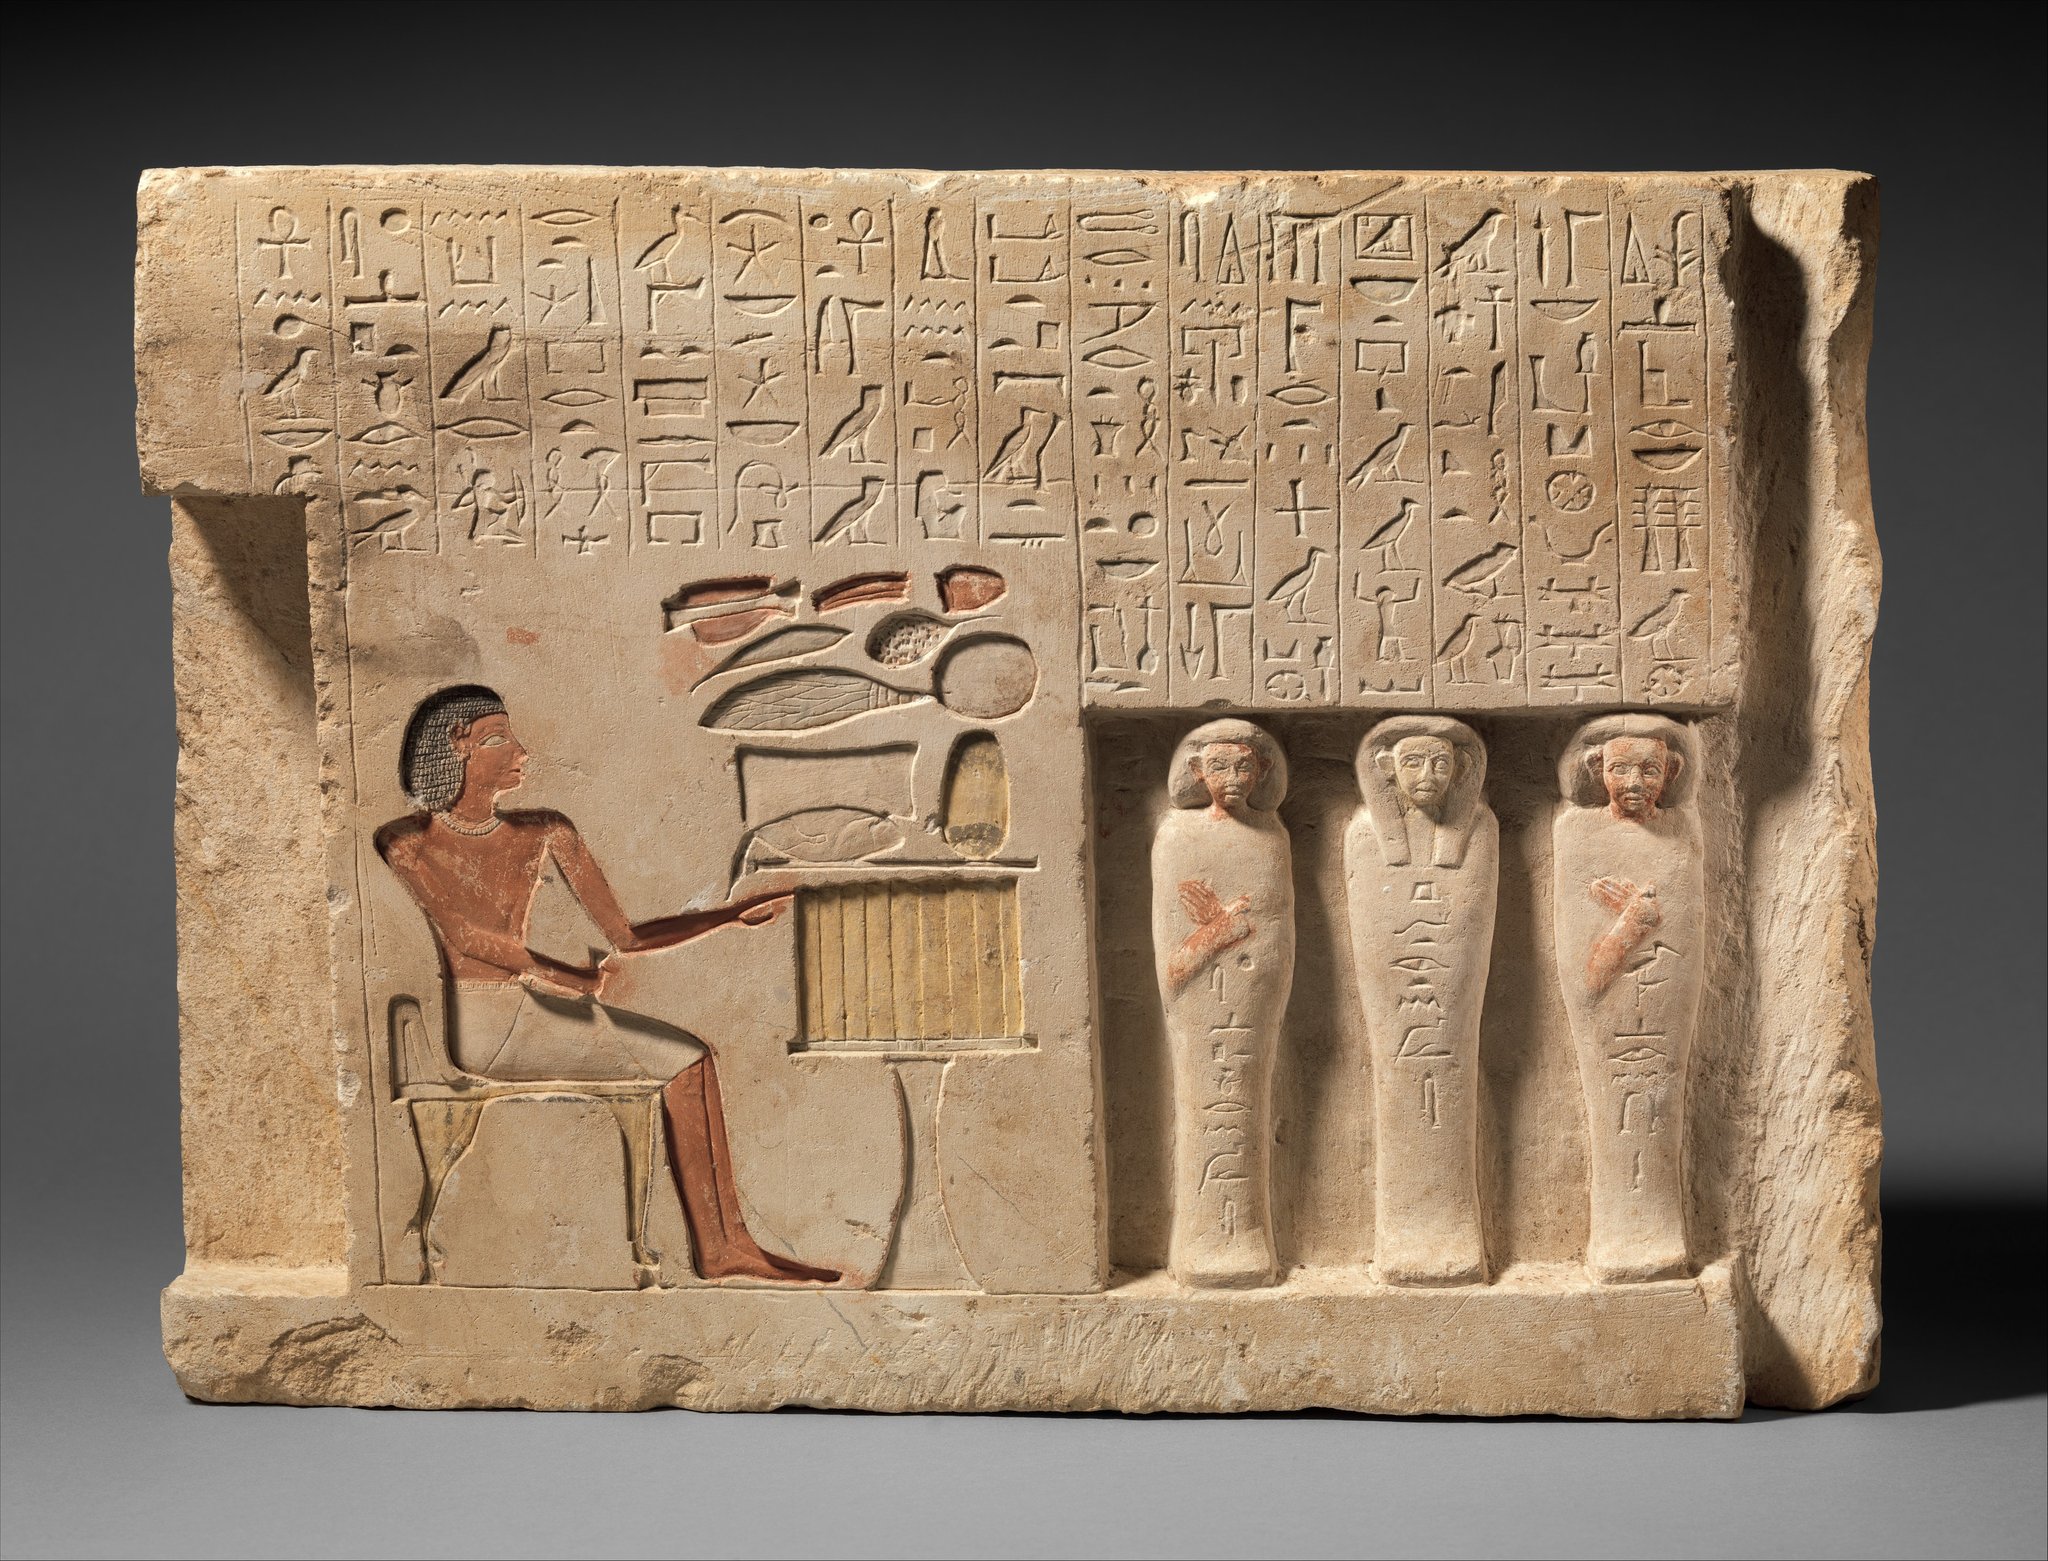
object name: relief, funerary chapel, sehetepibre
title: Relief from the Chapel of the Overseer of the Troops Sehetepibre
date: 1802-1640 BCE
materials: limestone, paint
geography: egypt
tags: men,hieroglyphs,mummies